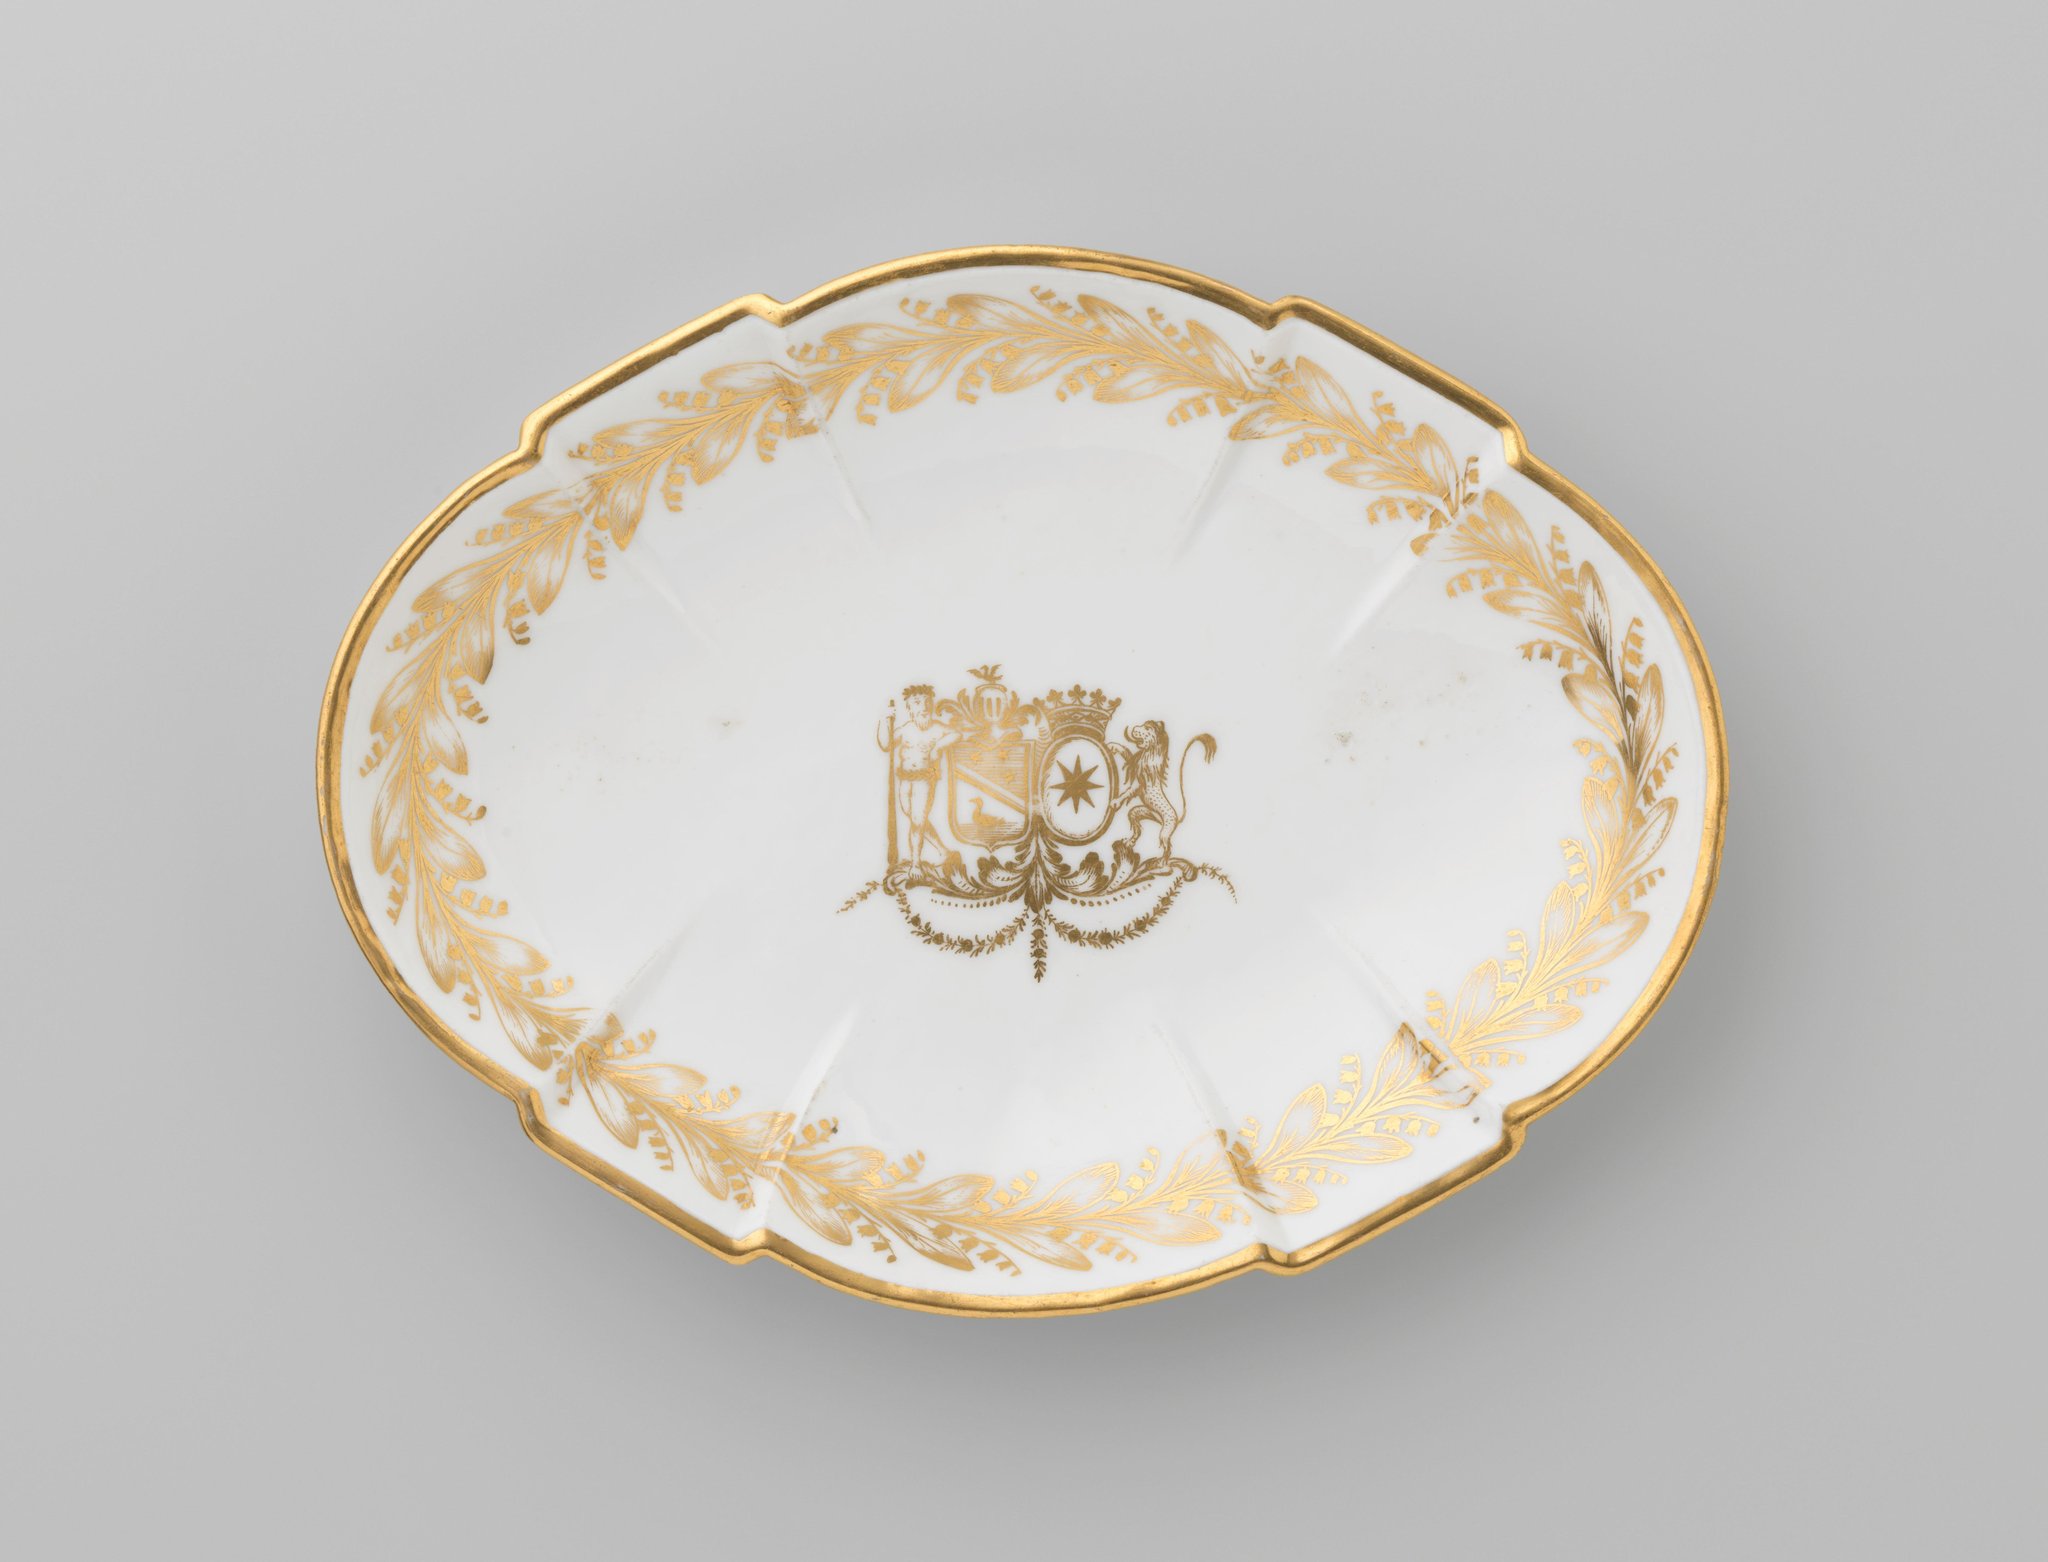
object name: dish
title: Dish with the coat of arms of Hendrik Peter Godfried Quack and Isabella Gertraud von Carnap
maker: Anonymous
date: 1790-1800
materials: glaze, gold, paint, porcelain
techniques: firing, forming, gilding, turning, vitrification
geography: netherlands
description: Ovale schaal van porselein met vier rechthoekige ribben in de wand, beschilderd op het glazuur met goud. Op het plat het alliantiewapen van Hendrik Peter Godfried Quack en Isabella Gertraud von Carnap. De binnenwand met een bloemrank en een gouden band op de rand. Drie proenen op de onderzijde.